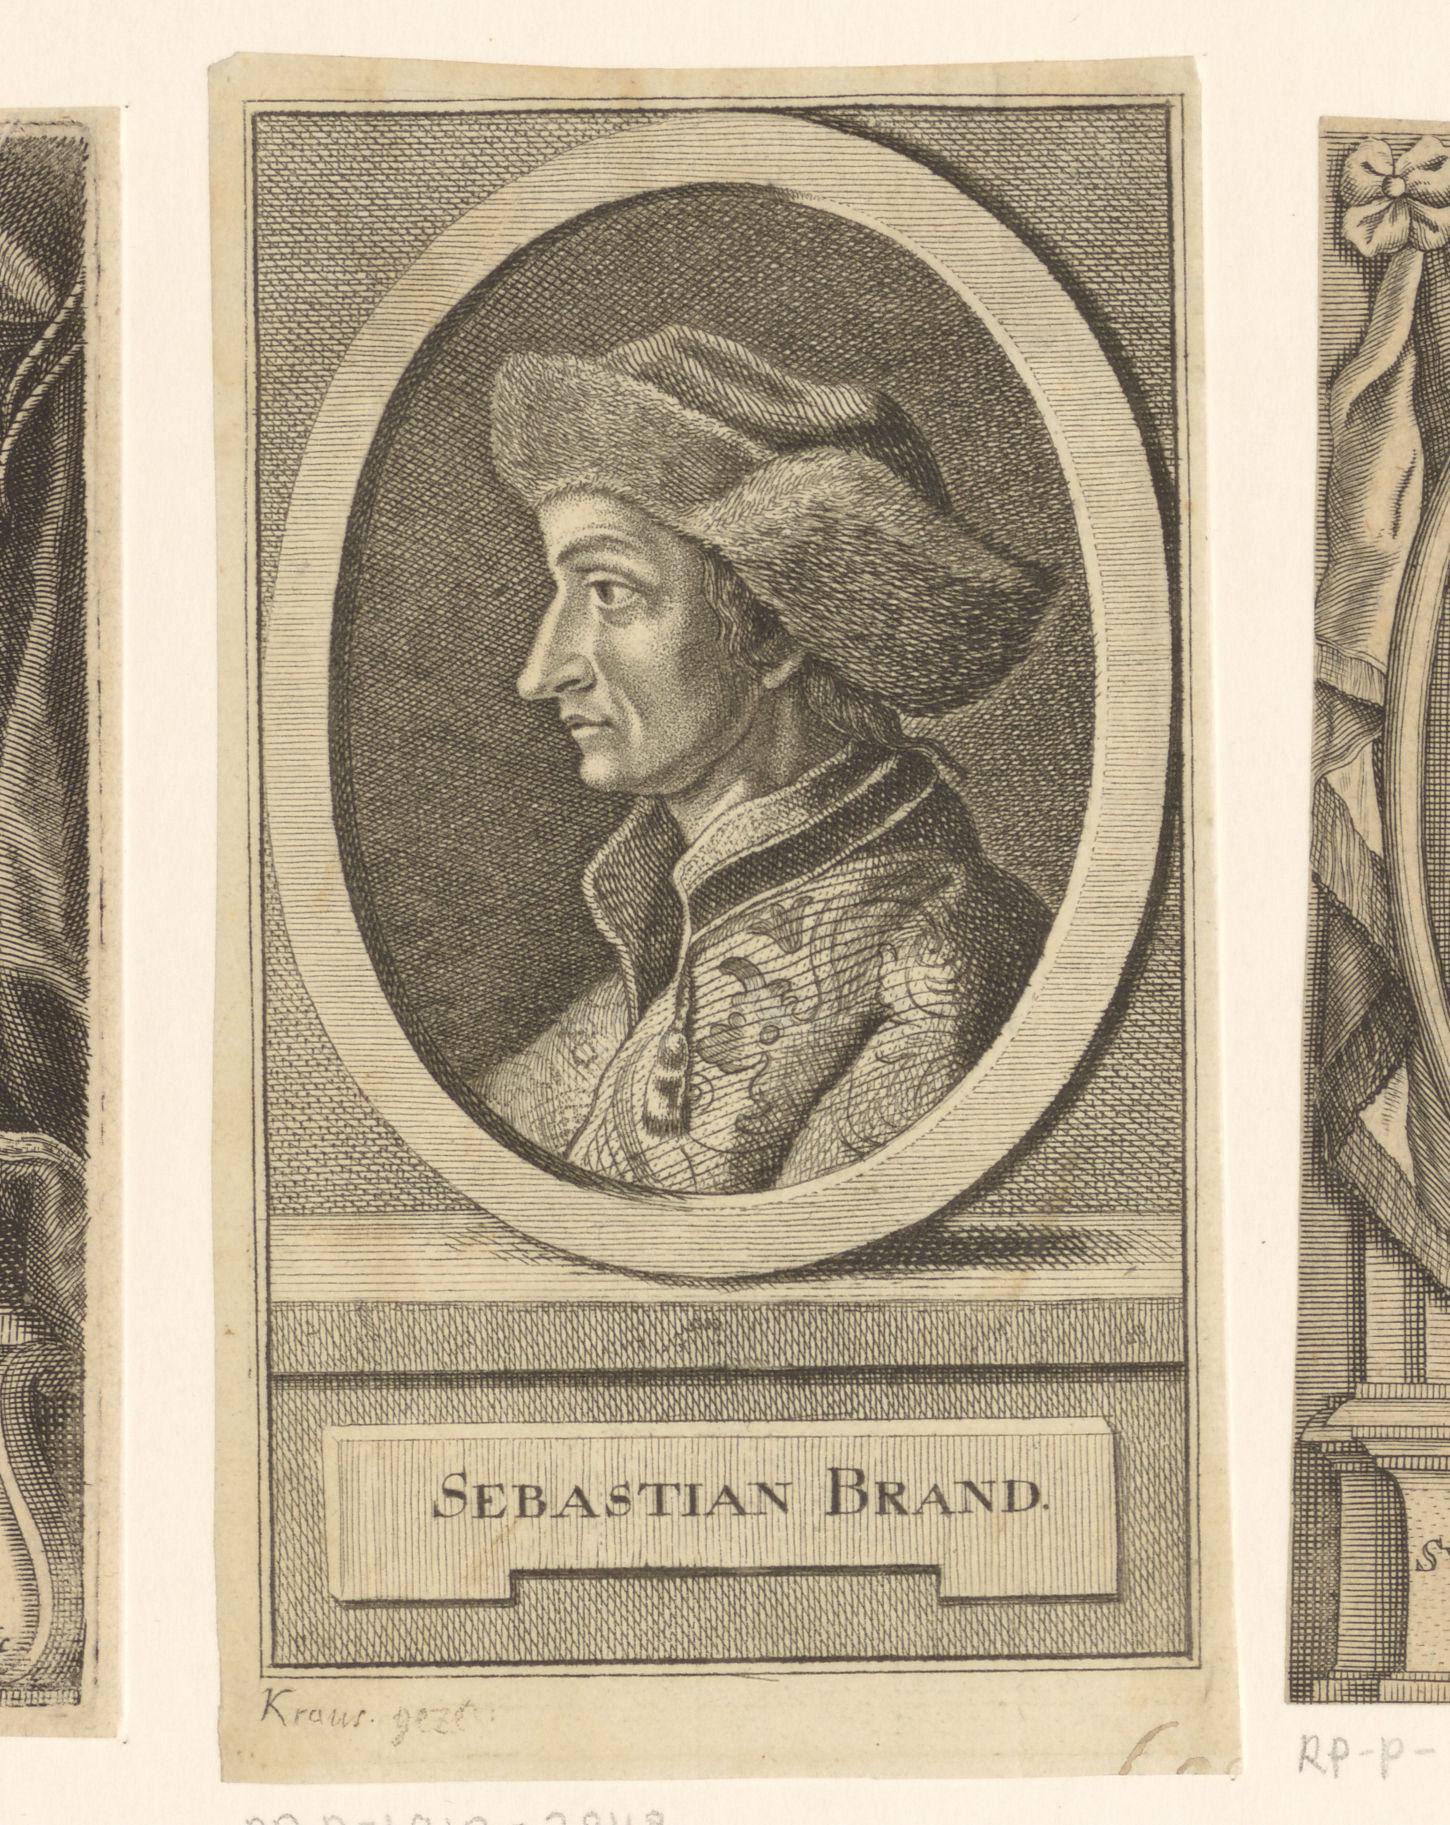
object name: print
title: Portret van Sebastian Brant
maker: jodocus egidius krauss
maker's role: print maker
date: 1705-1753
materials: paper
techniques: engraving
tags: sebastian brant, historical persons, lawyer, attorney at law, writer, poet, author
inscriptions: collector's mark: Lugt 2228